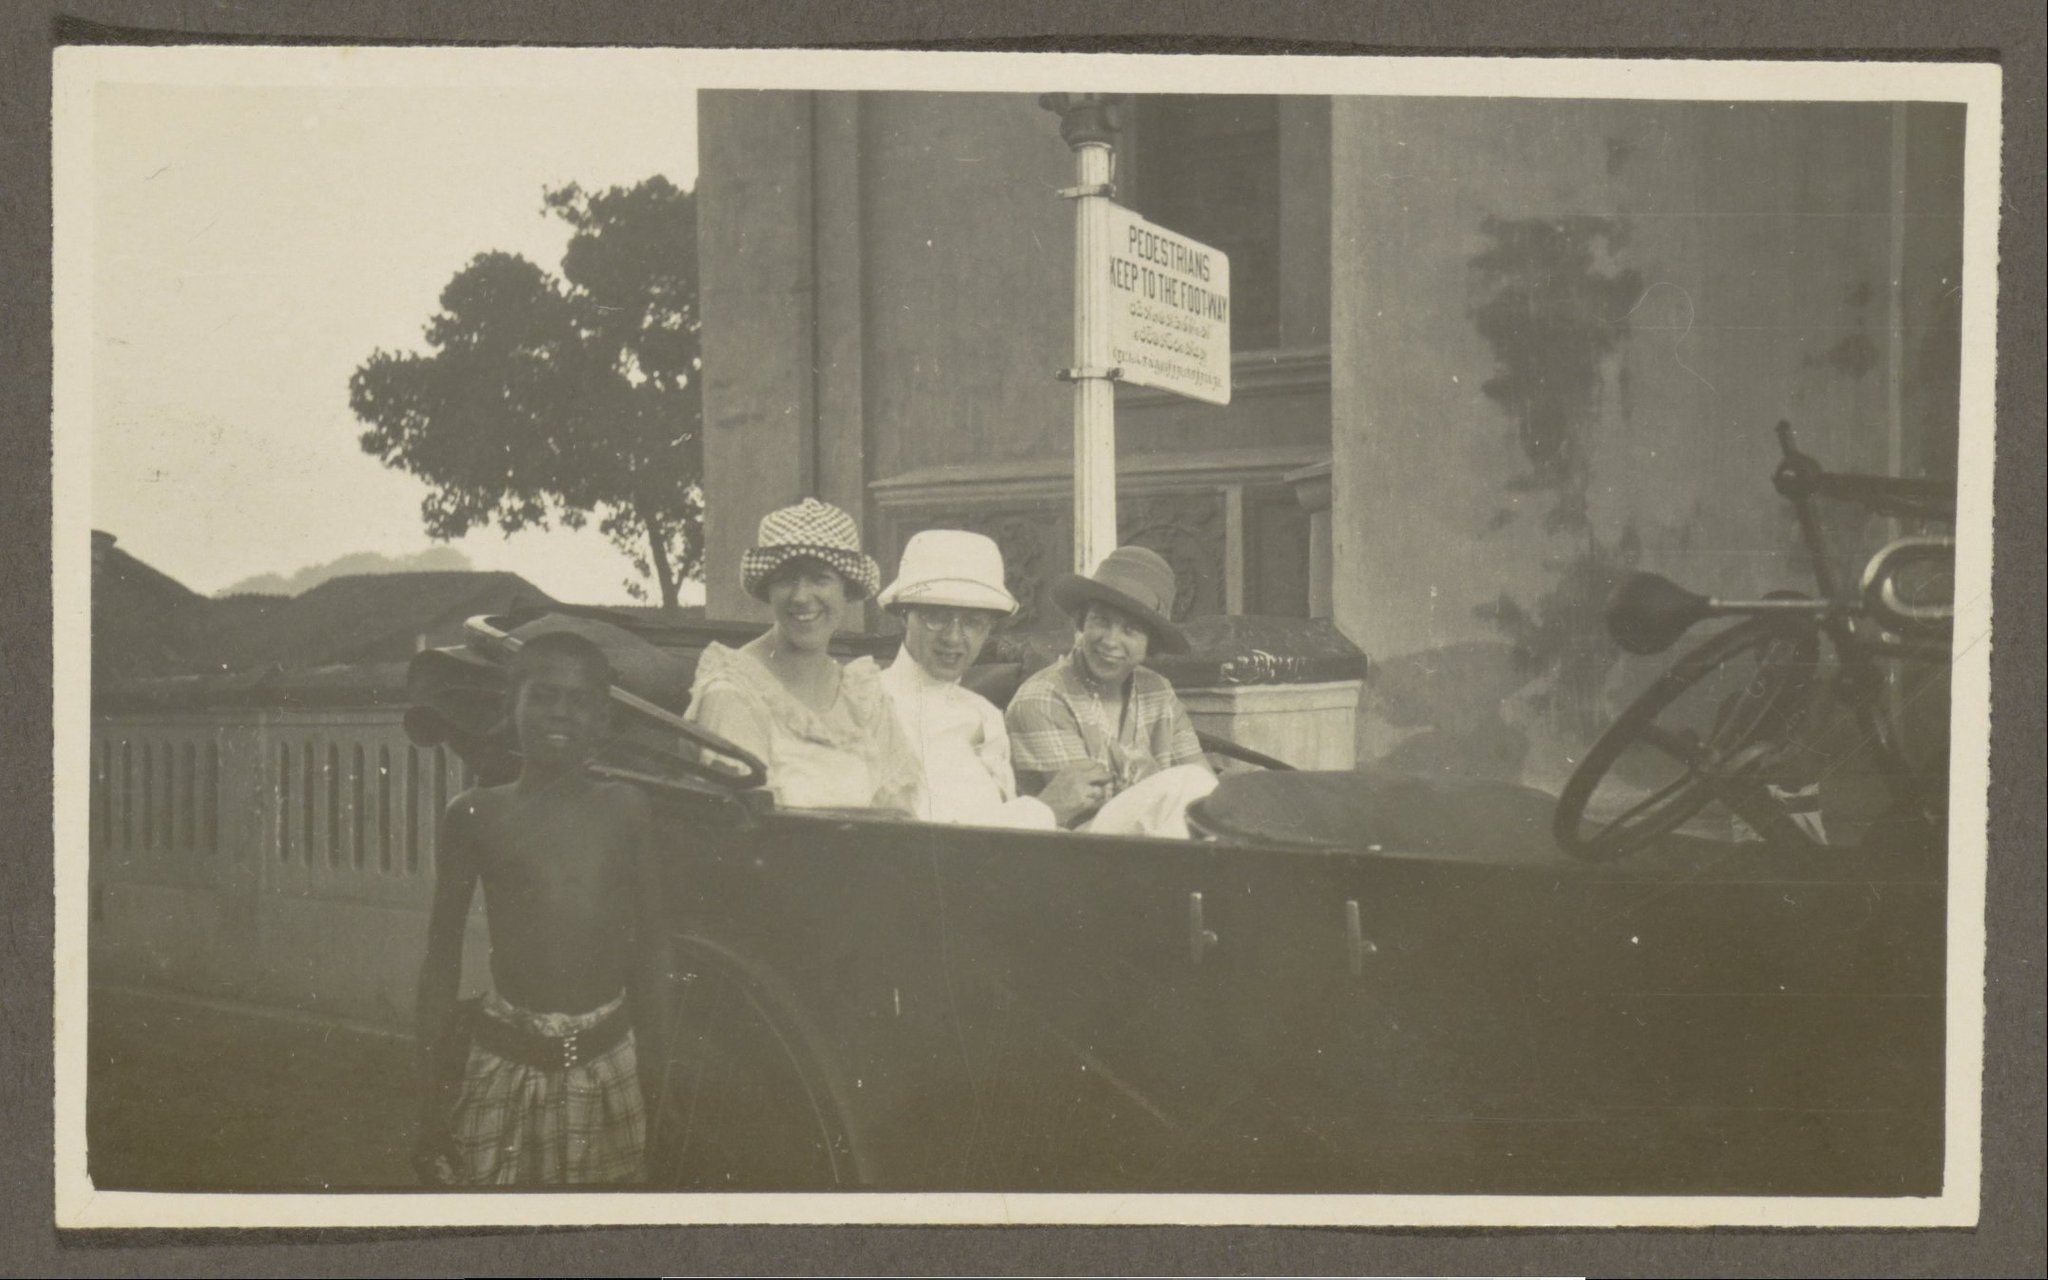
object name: photograph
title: Drietal zittend op de achterbank van een auto, vooraan een jongen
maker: Anonymous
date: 1920-1930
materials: photographic support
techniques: gelatin silver print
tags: automobile (+ three persons ~ traffic and transport), sri lanka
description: Twee vrouwen en een man, allen in westerse kledij, zitten op de achterbank van een cabriolet. Op de voorgrond een jongen met lendendoek en riem. Op de achtergrond een verkeersbord, onder meer in het Engels. Onderdeel van familiealbum Nederlands-Indië.